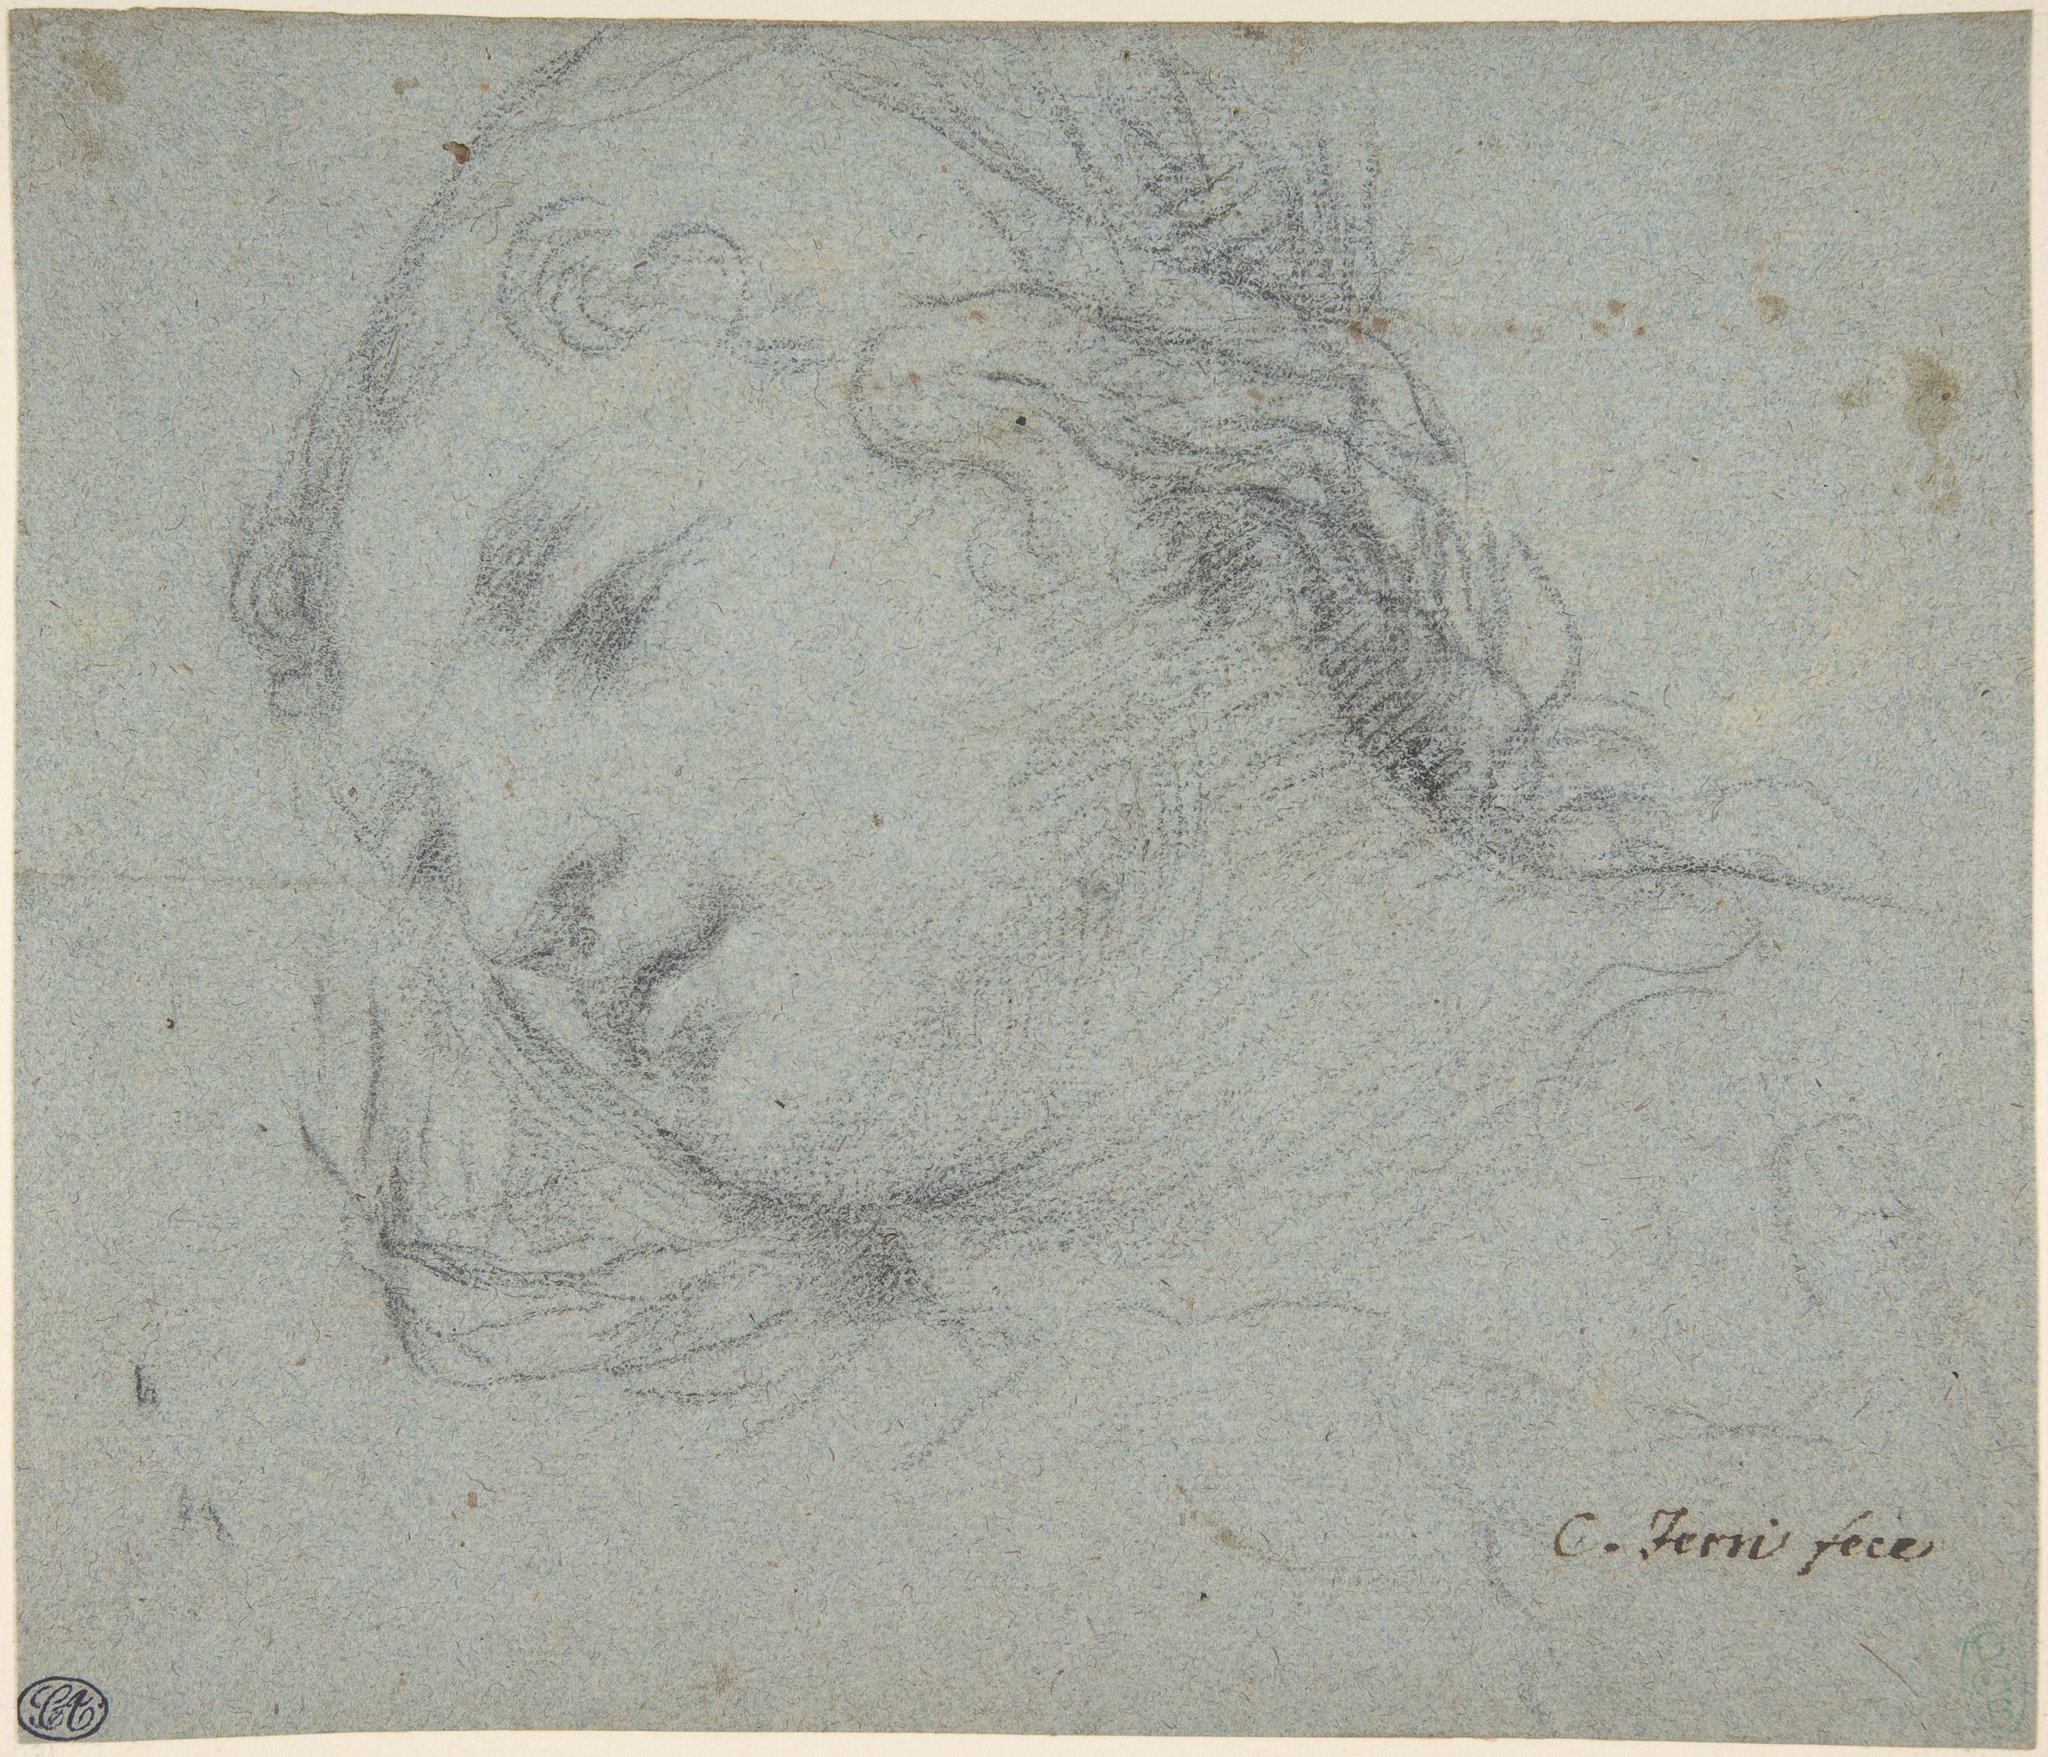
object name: drawing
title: Head of a Woman (recto); Head of a Child, Study of Children's Forearms (verso)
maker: ciro ferri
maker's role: artist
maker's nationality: italian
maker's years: 1634-1689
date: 1634-1689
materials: chalk, paper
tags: heads,portraits,women